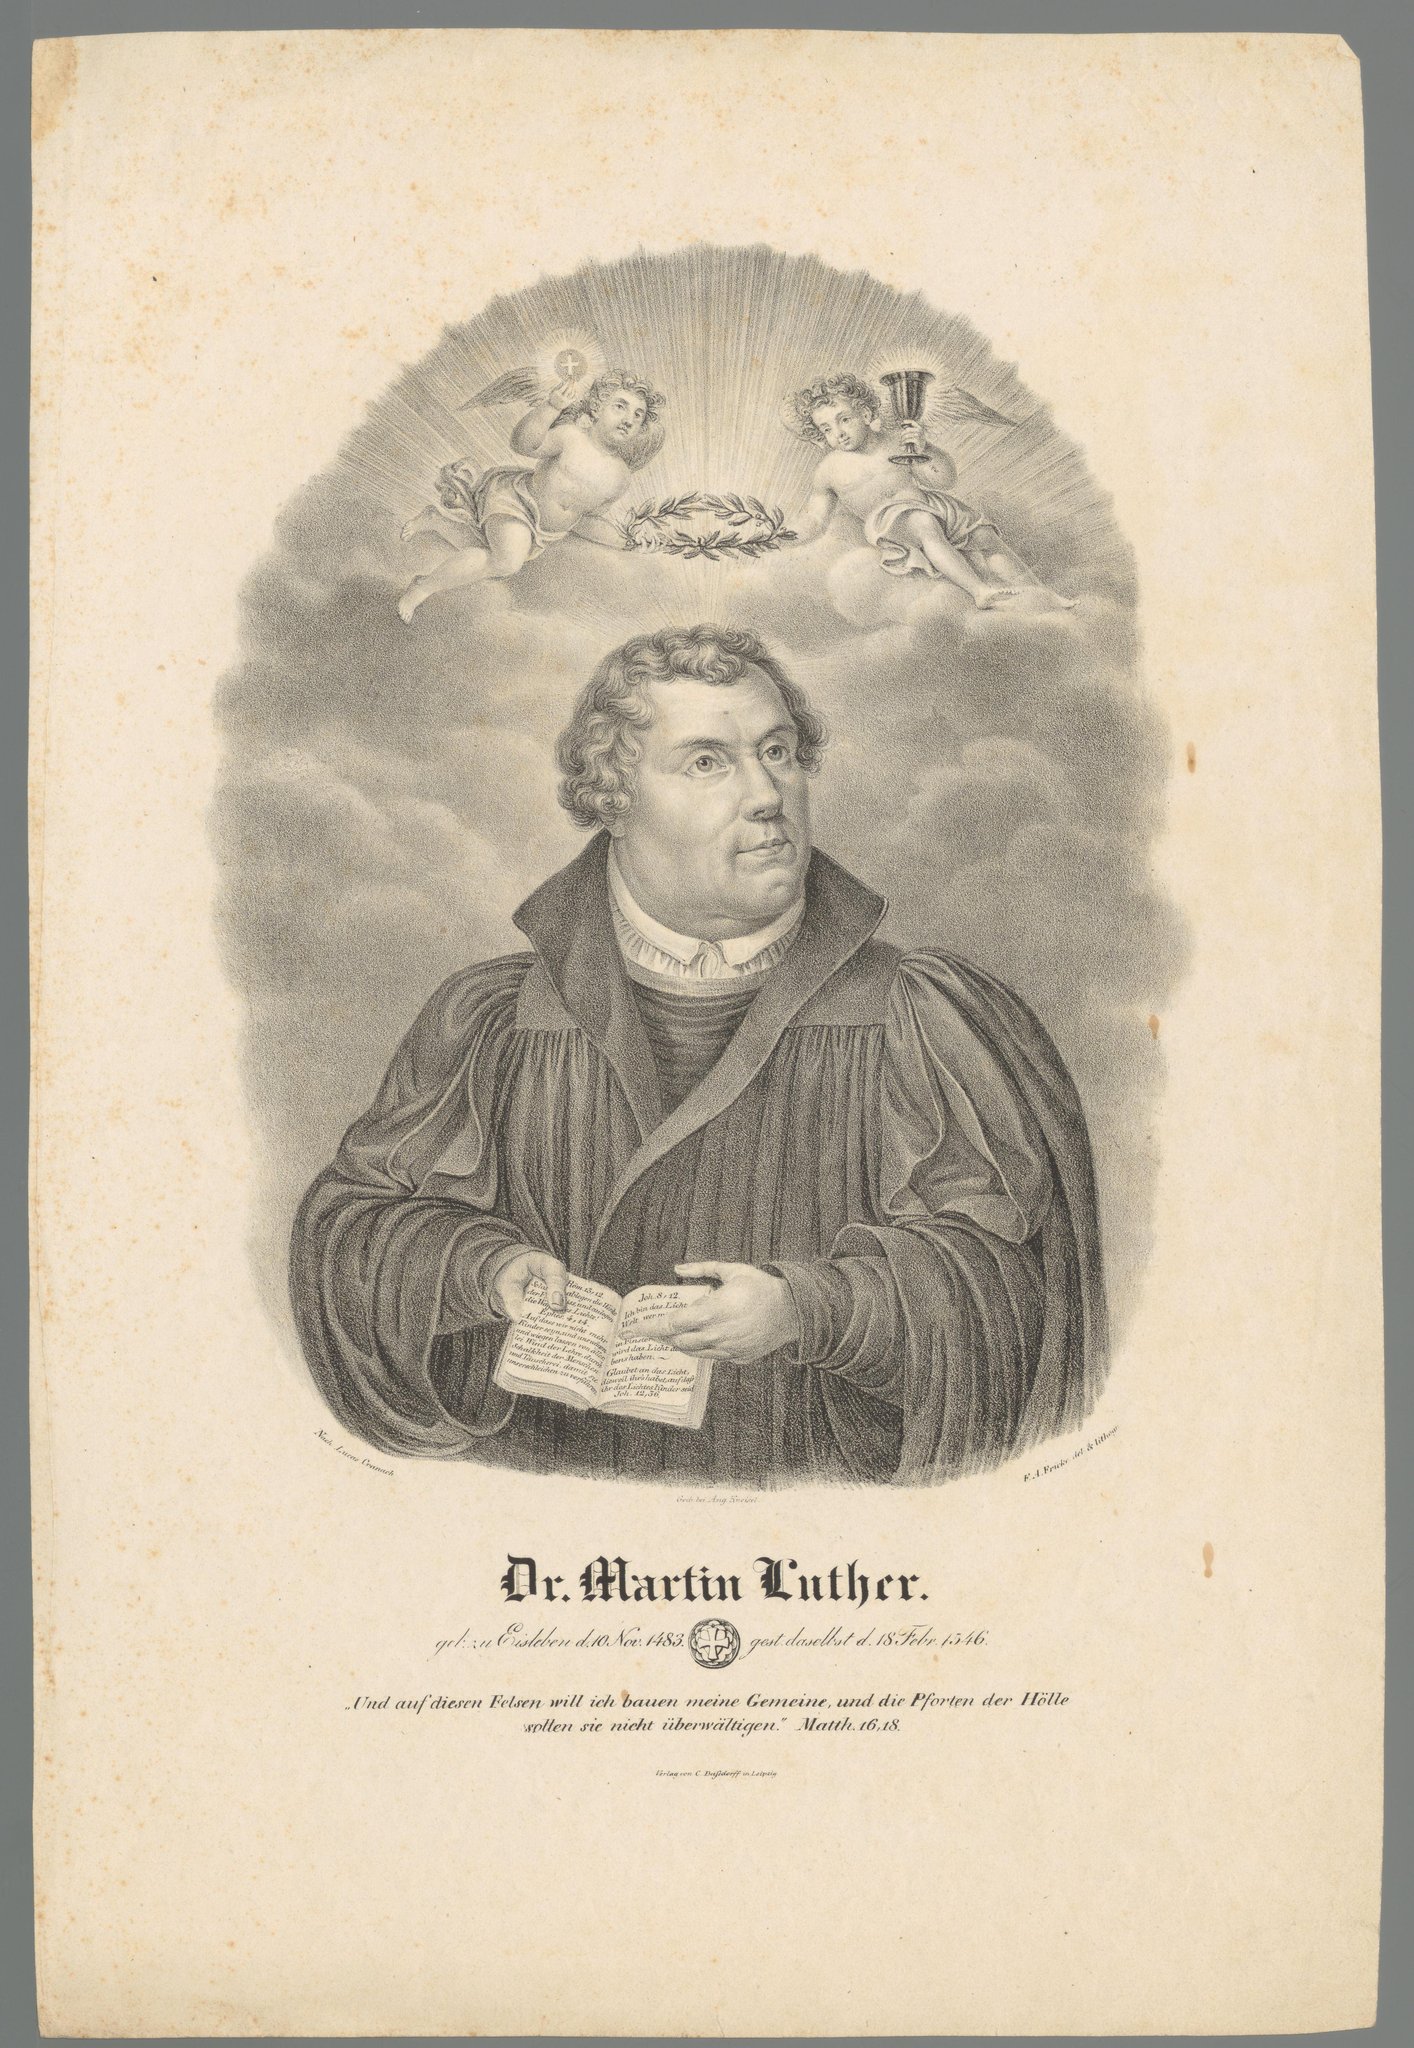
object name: print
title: Portret van Martin Luther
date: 1794-1858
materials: paper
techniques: lithograph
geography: leipzig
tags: priest, martin luther, adult man, historical persons, the bible as a book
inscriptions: collector's mark: Lugt 2228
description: Luther houdt in zijn handen een bijbel vast.